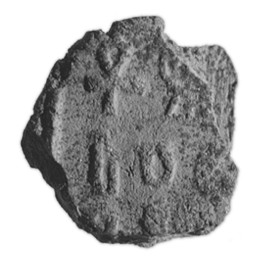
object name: sealing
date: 2030-1640 BCE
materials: clay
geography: egypt